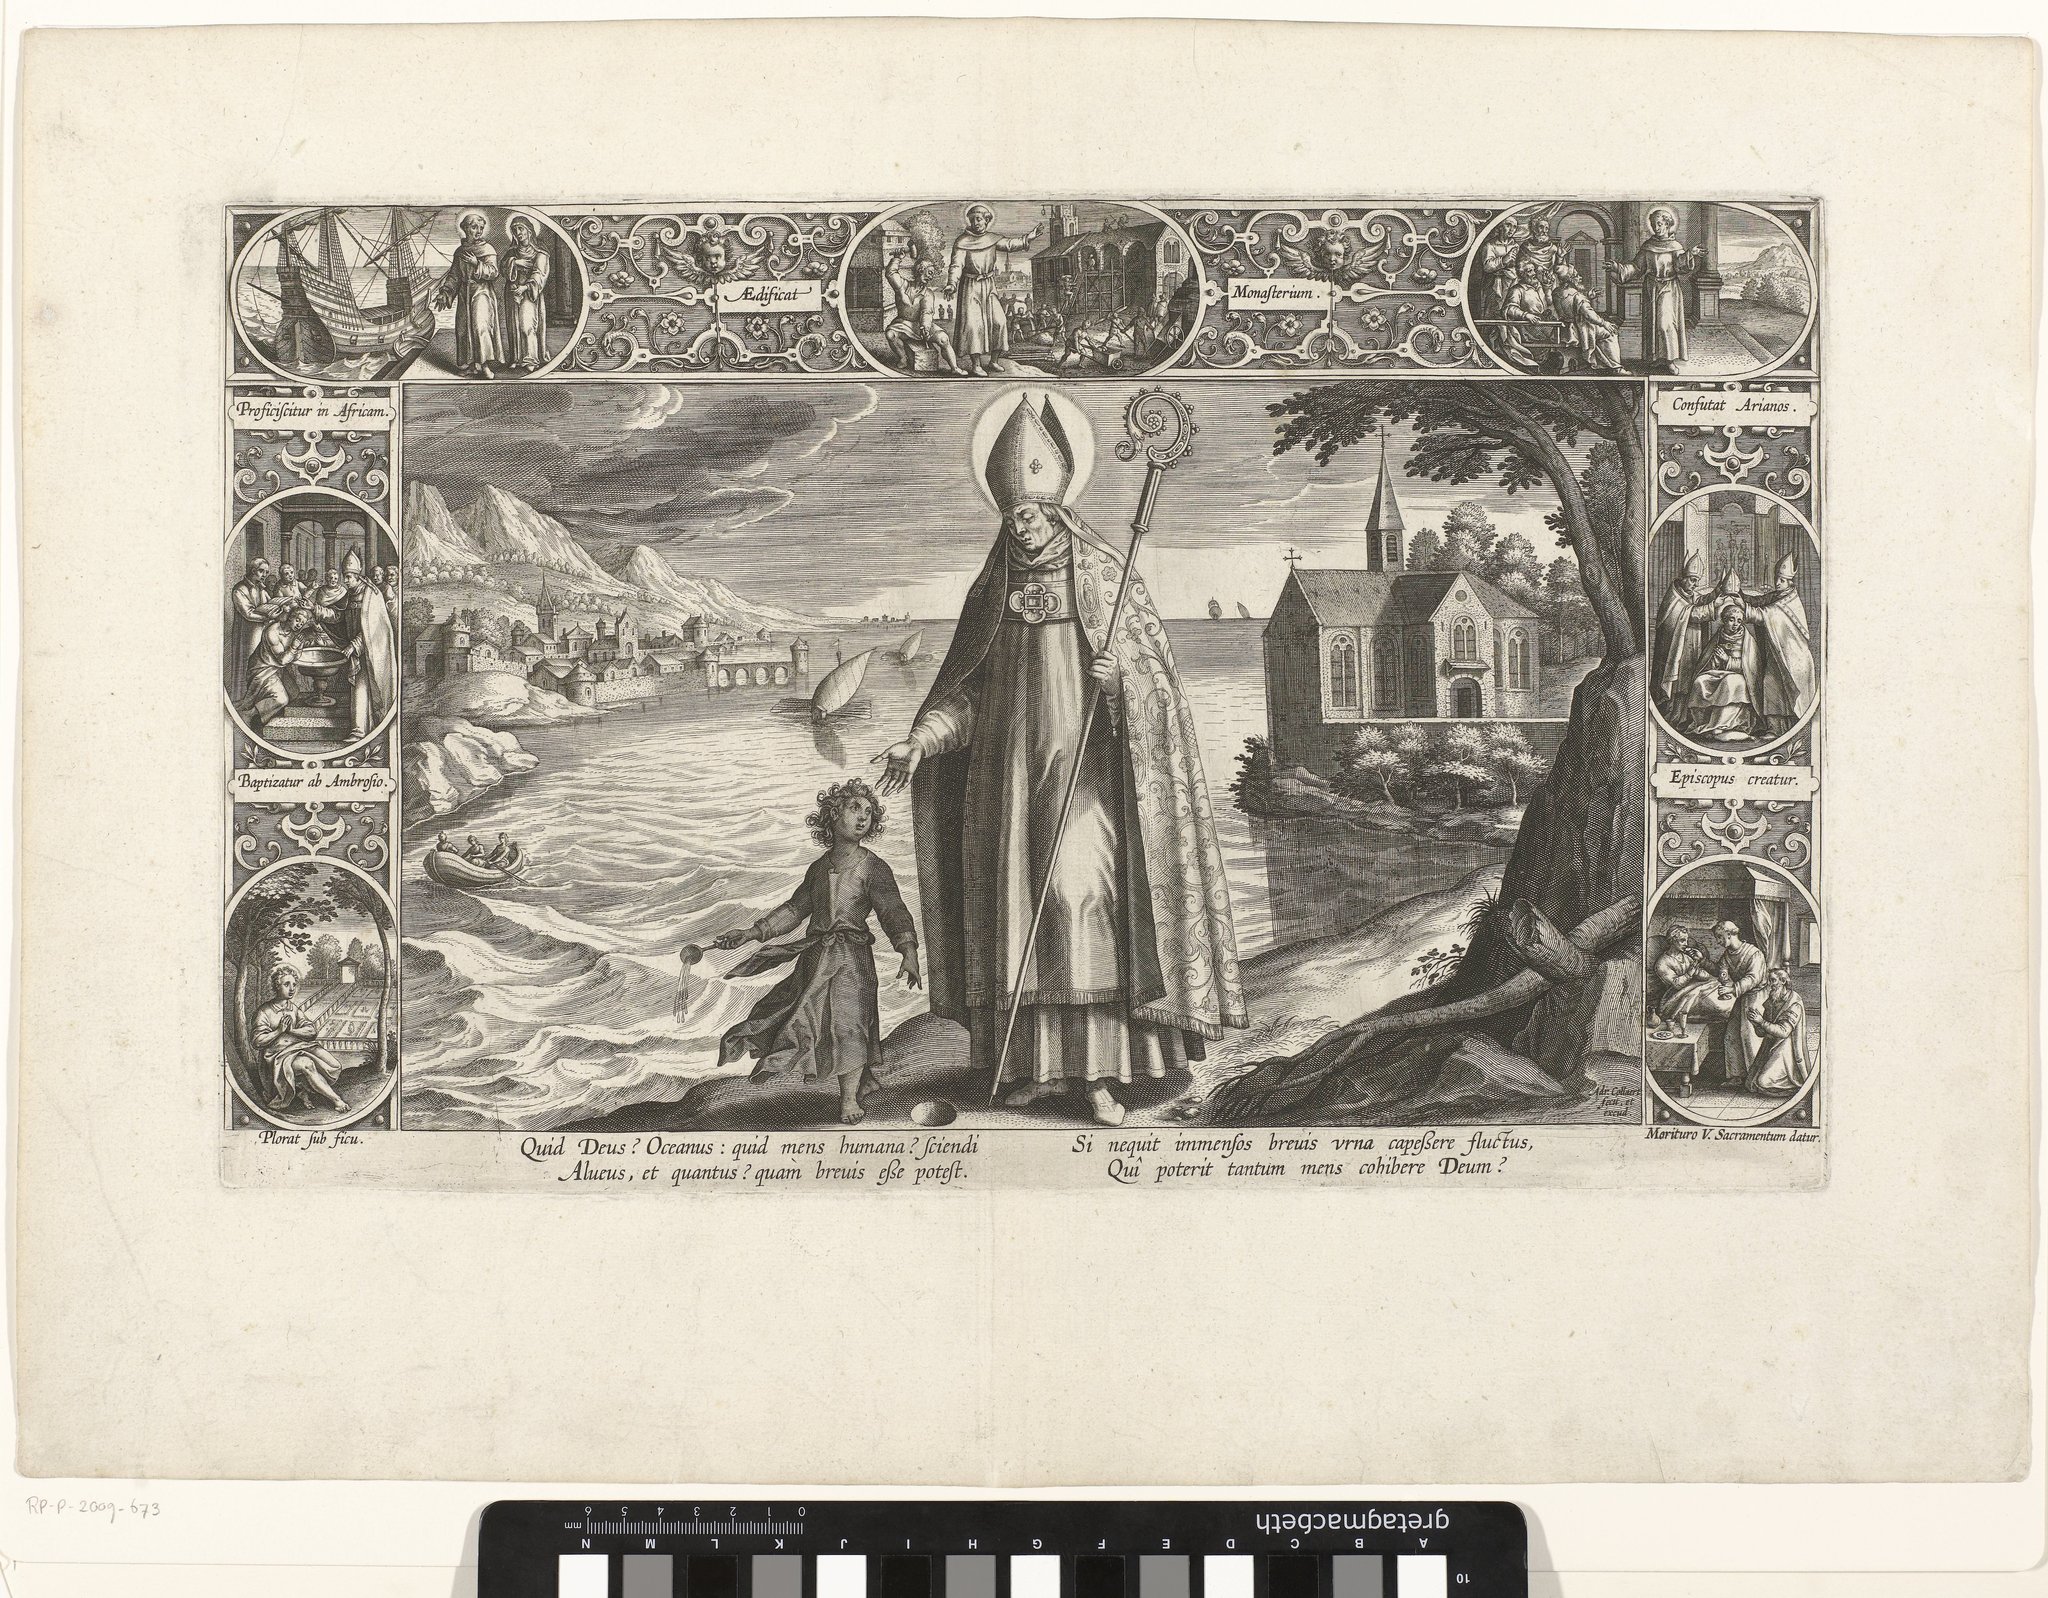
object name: print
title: De Heilige Augustinus en het kind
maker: adriaen collaert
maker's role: draughtsman, print maker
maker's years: 1560-1618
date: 1570-1618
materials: paper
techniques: engraving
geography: antwerp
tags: augustine, bishop of hippo; possible attributes: arrows piercing his breast, book, child with spoon, flaming heart, heart (pierced with arrows), pen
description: Heilige Augustinus aan de rand van een meer met links gezicht op een stad en rechts een kerk. Links van hem schept een kind met een lepel water uit het meer in een gat in de grond. Omlijsting met ornamenten en scènes uit het leven van de Heilige Augustinus. Van links onderaan naar rechts onderaan: Augustinus biddend in een tuin, Ambrosius doopt Augustinus, vertrek met schip naar Afrika, Augustinus tussen werkende mensen, Augustinus in het klooster, Augustinus wordt tot bisschop gewijd, Augustinus ontvangt het Heilige Sacrament. Met onderschrift: Quid Deus ? ...mens cohibere Deum?